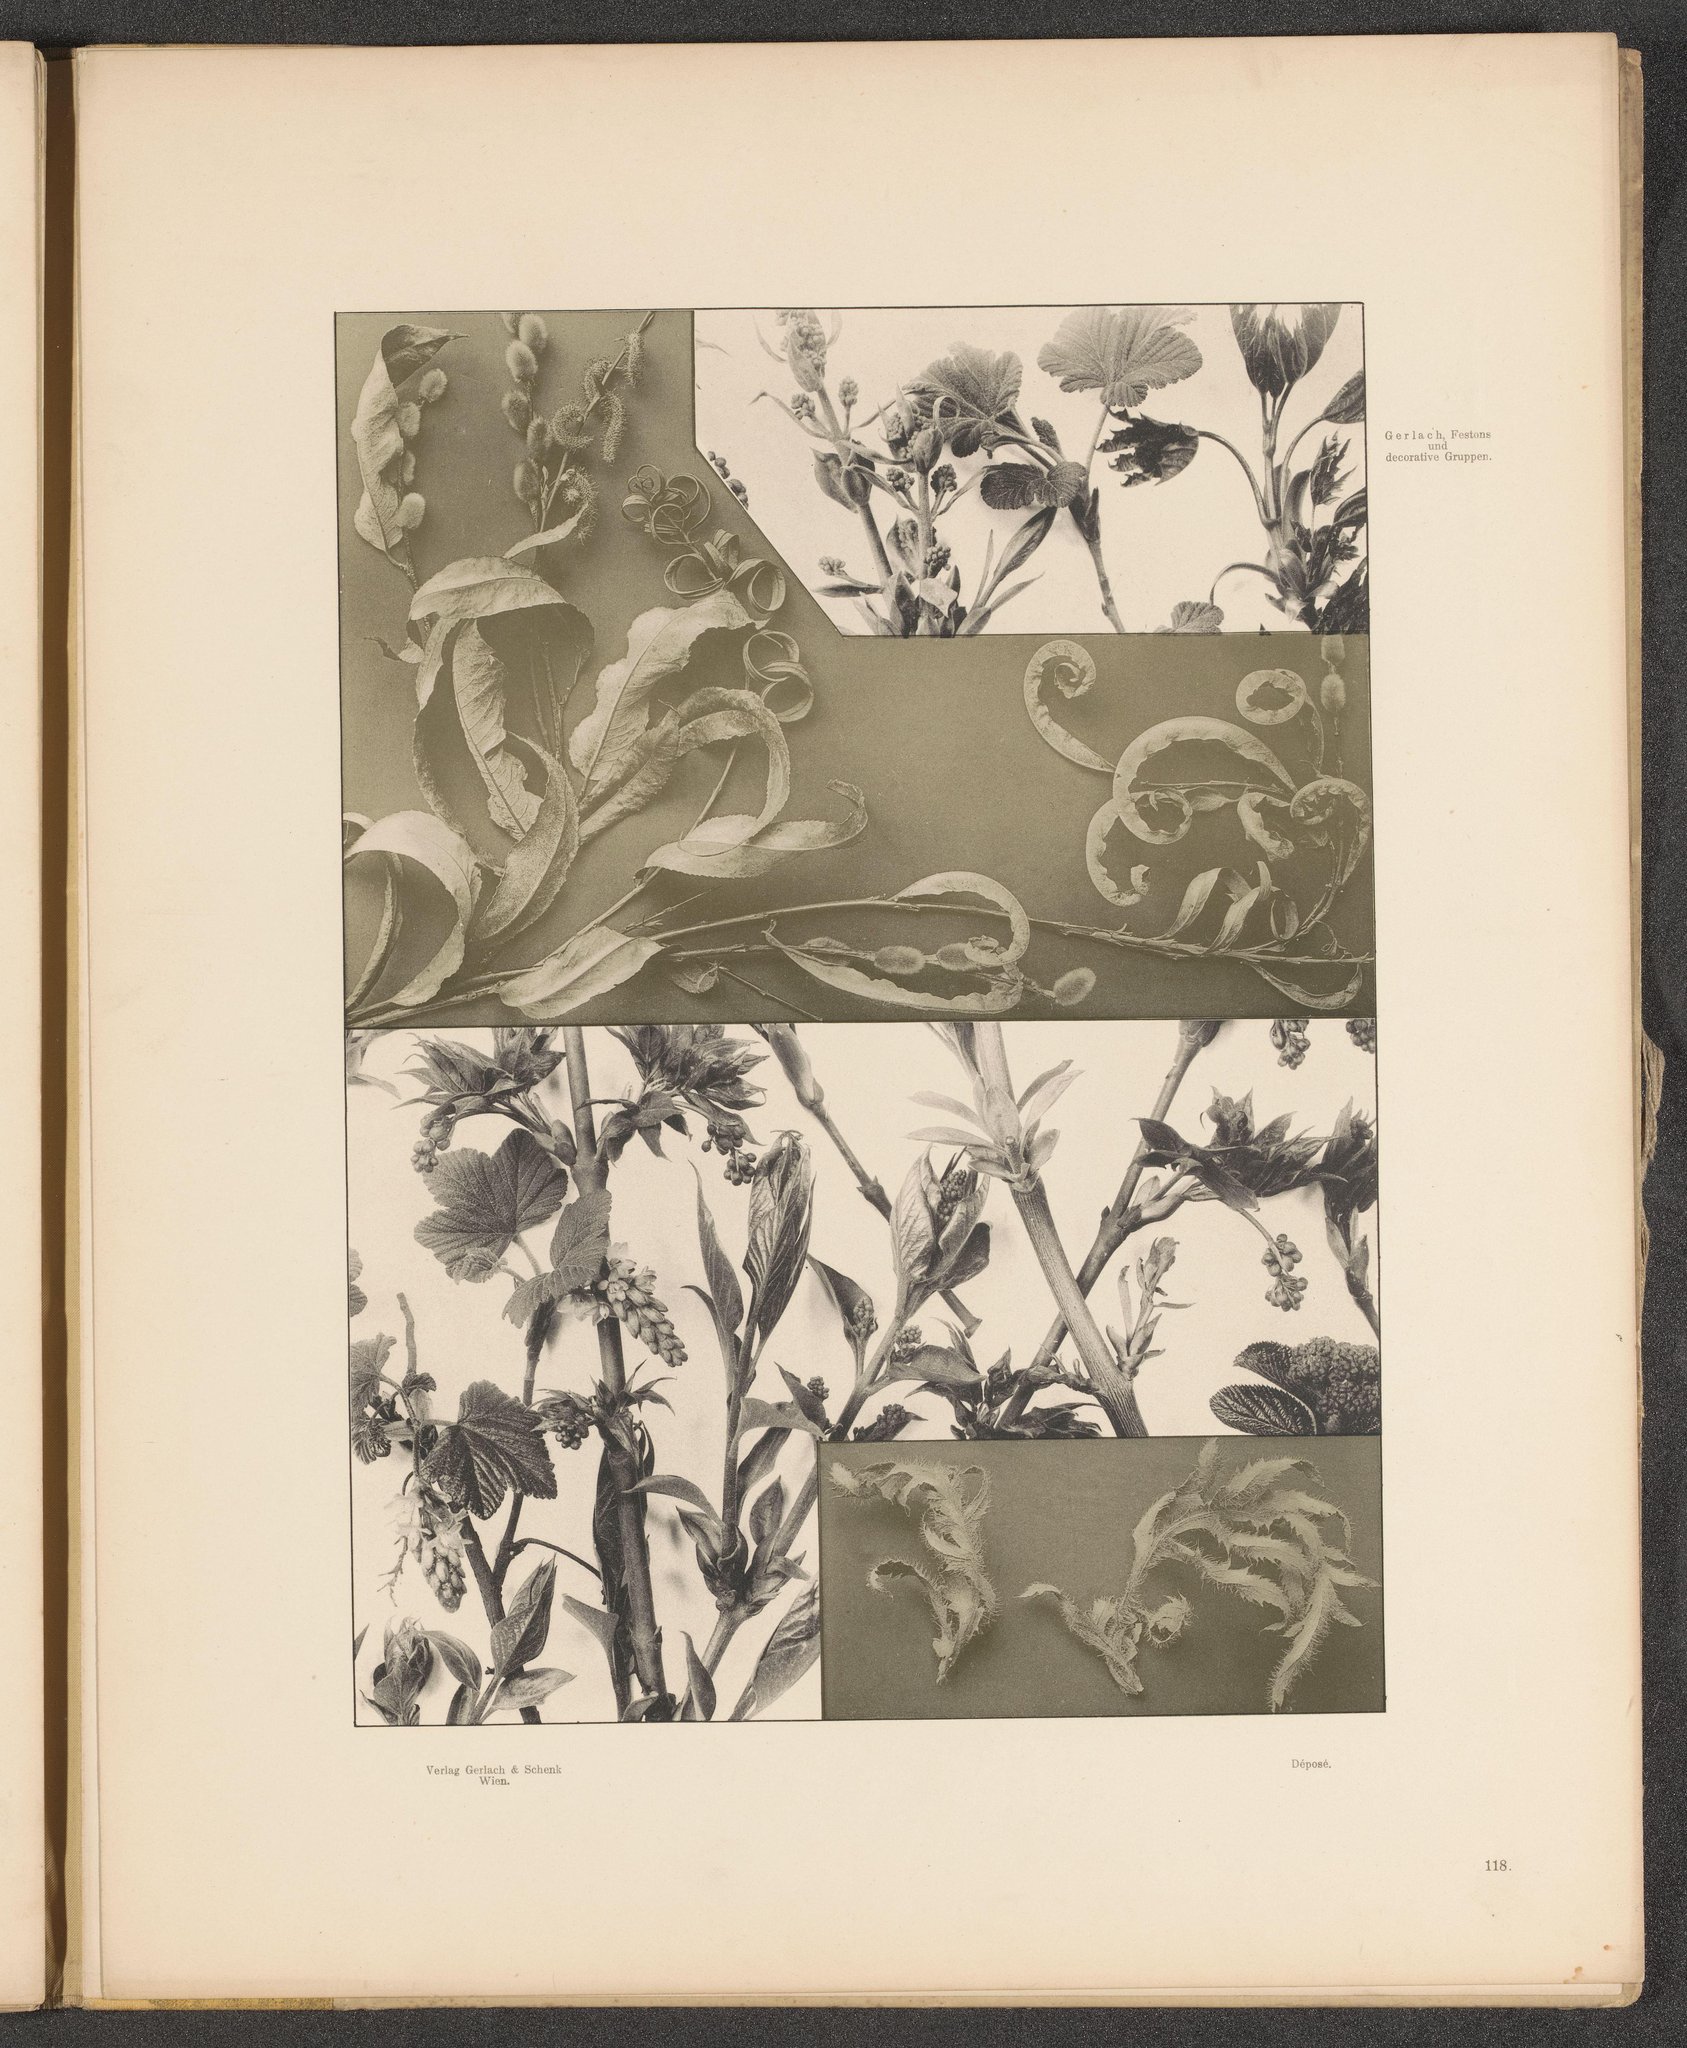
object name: page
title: Vlakken met esdoornbladeren, aalbessen, pimpernoot en klaproosbladeren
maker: Anonymous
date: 1887-1897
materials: paper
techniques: photograph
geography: vienna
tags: foliage, tendrils, branches ~ ornament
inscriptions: number: ‘118.’